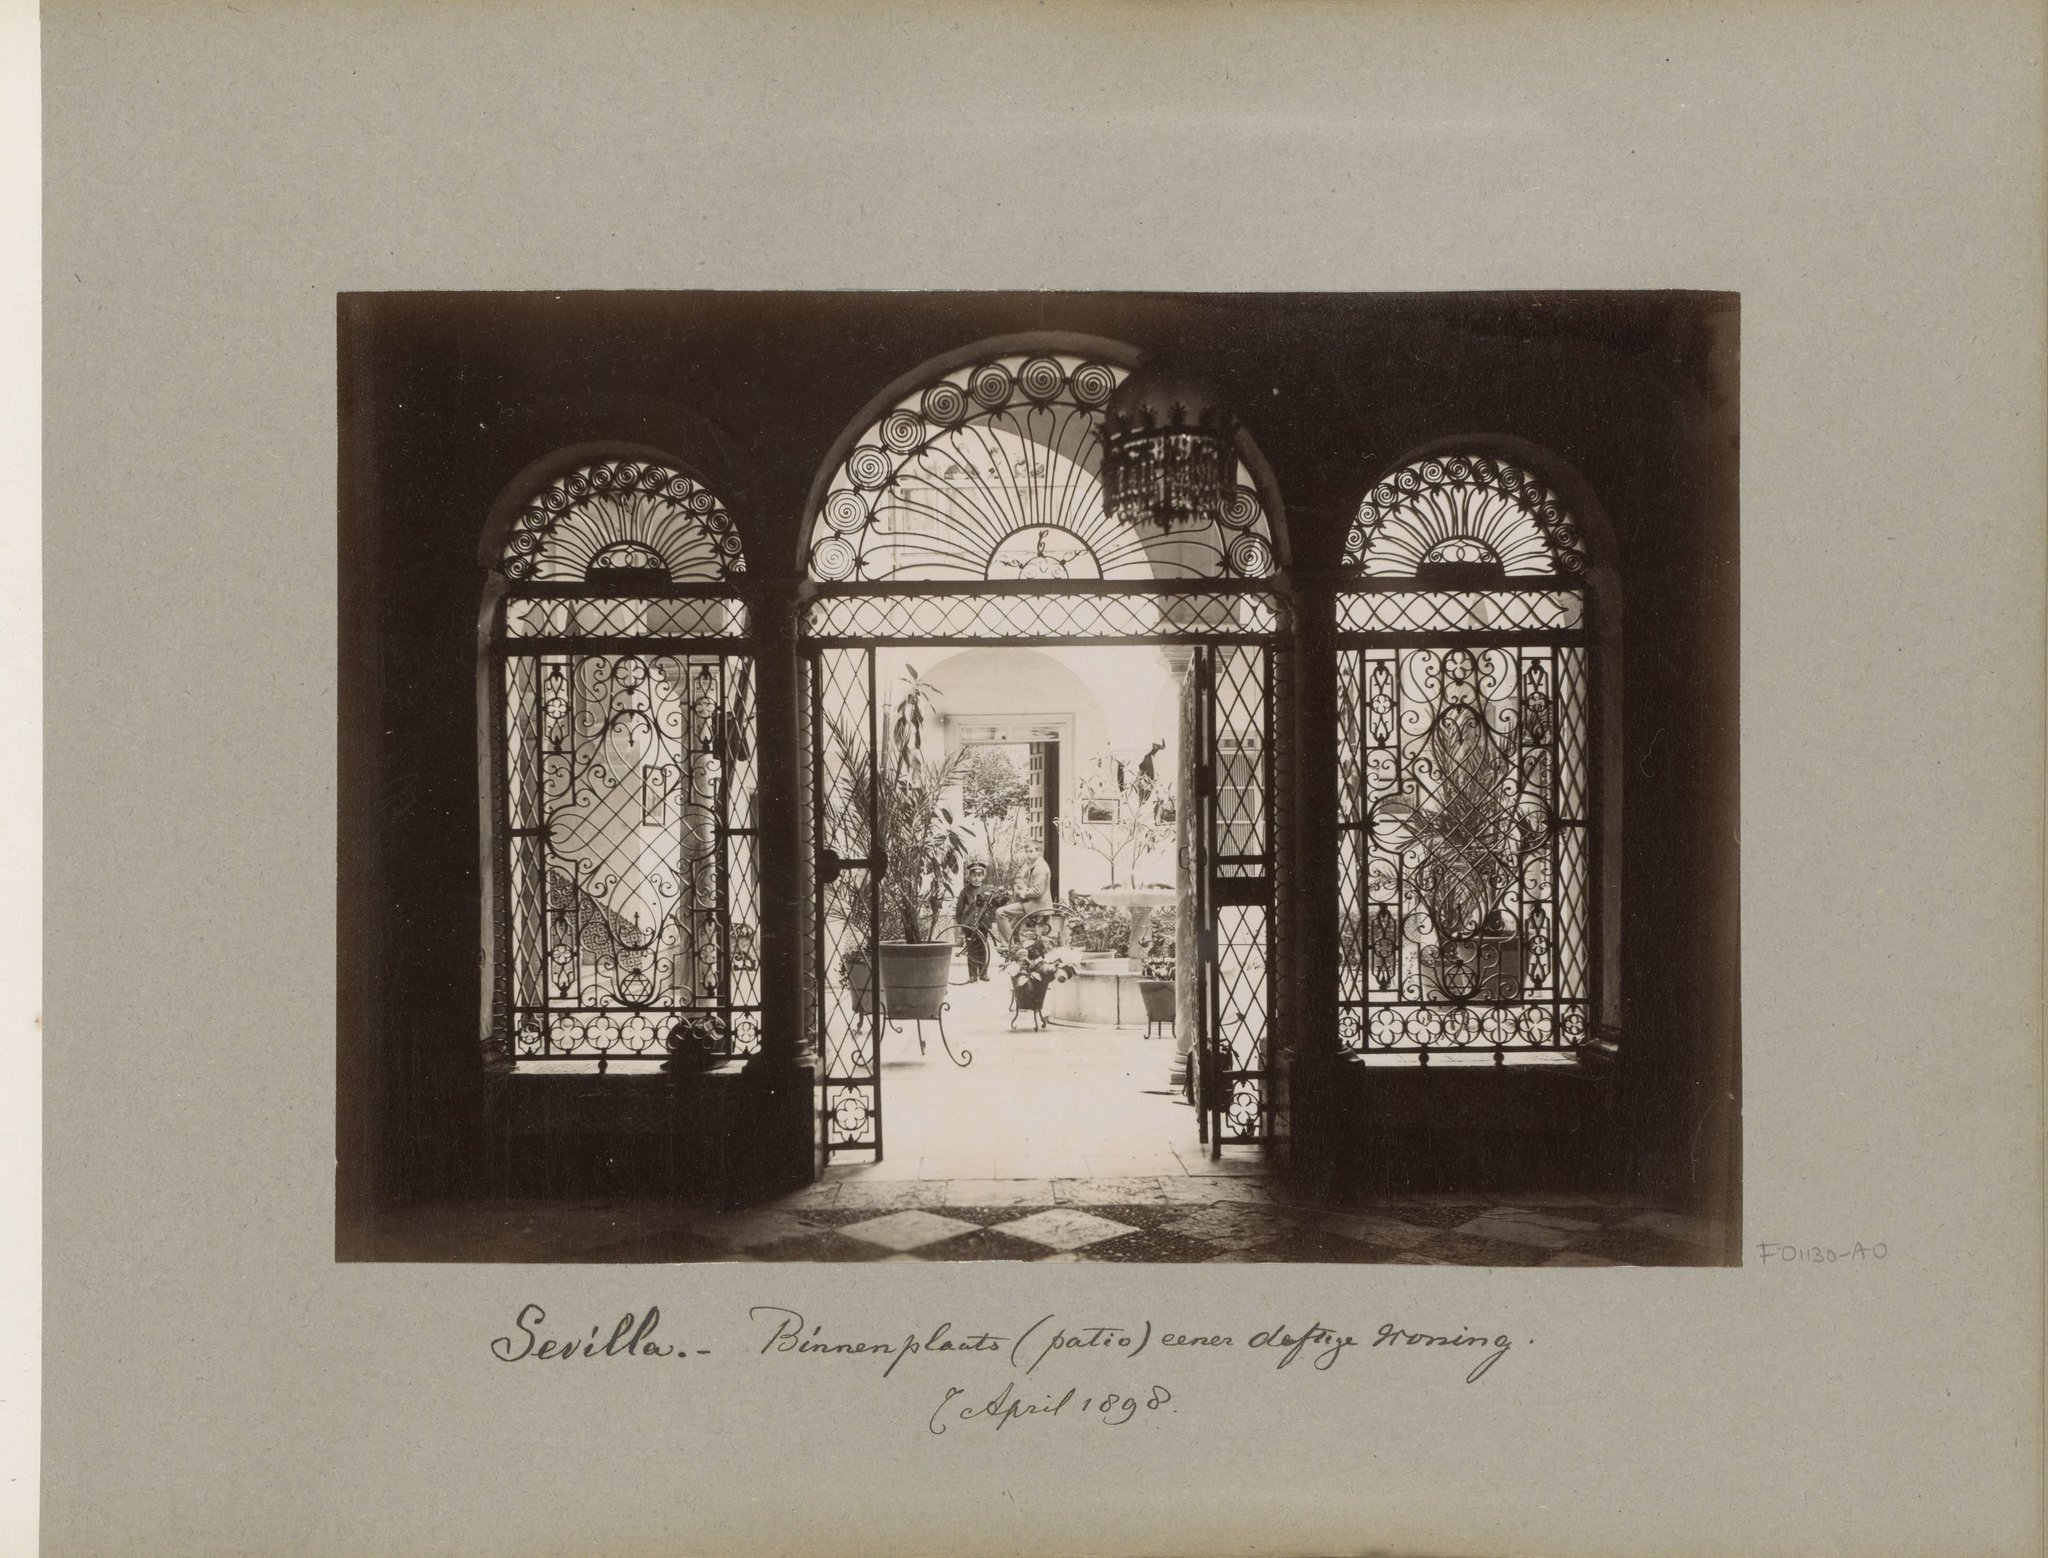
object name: album leaf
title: Patio in Sevilla met jongens op een fiets en in uniform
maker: Anonymous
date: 1880-1898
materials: paper, photographic support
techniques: albumen print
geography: sevilla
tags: bicycle, courtyard, sevilla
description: Onderdeel van Reisalbum met foto's van bezienswaardigheden in Frankrijk, Spanje, Italië, Duitsland, Zwitserland en Oostenrijk.